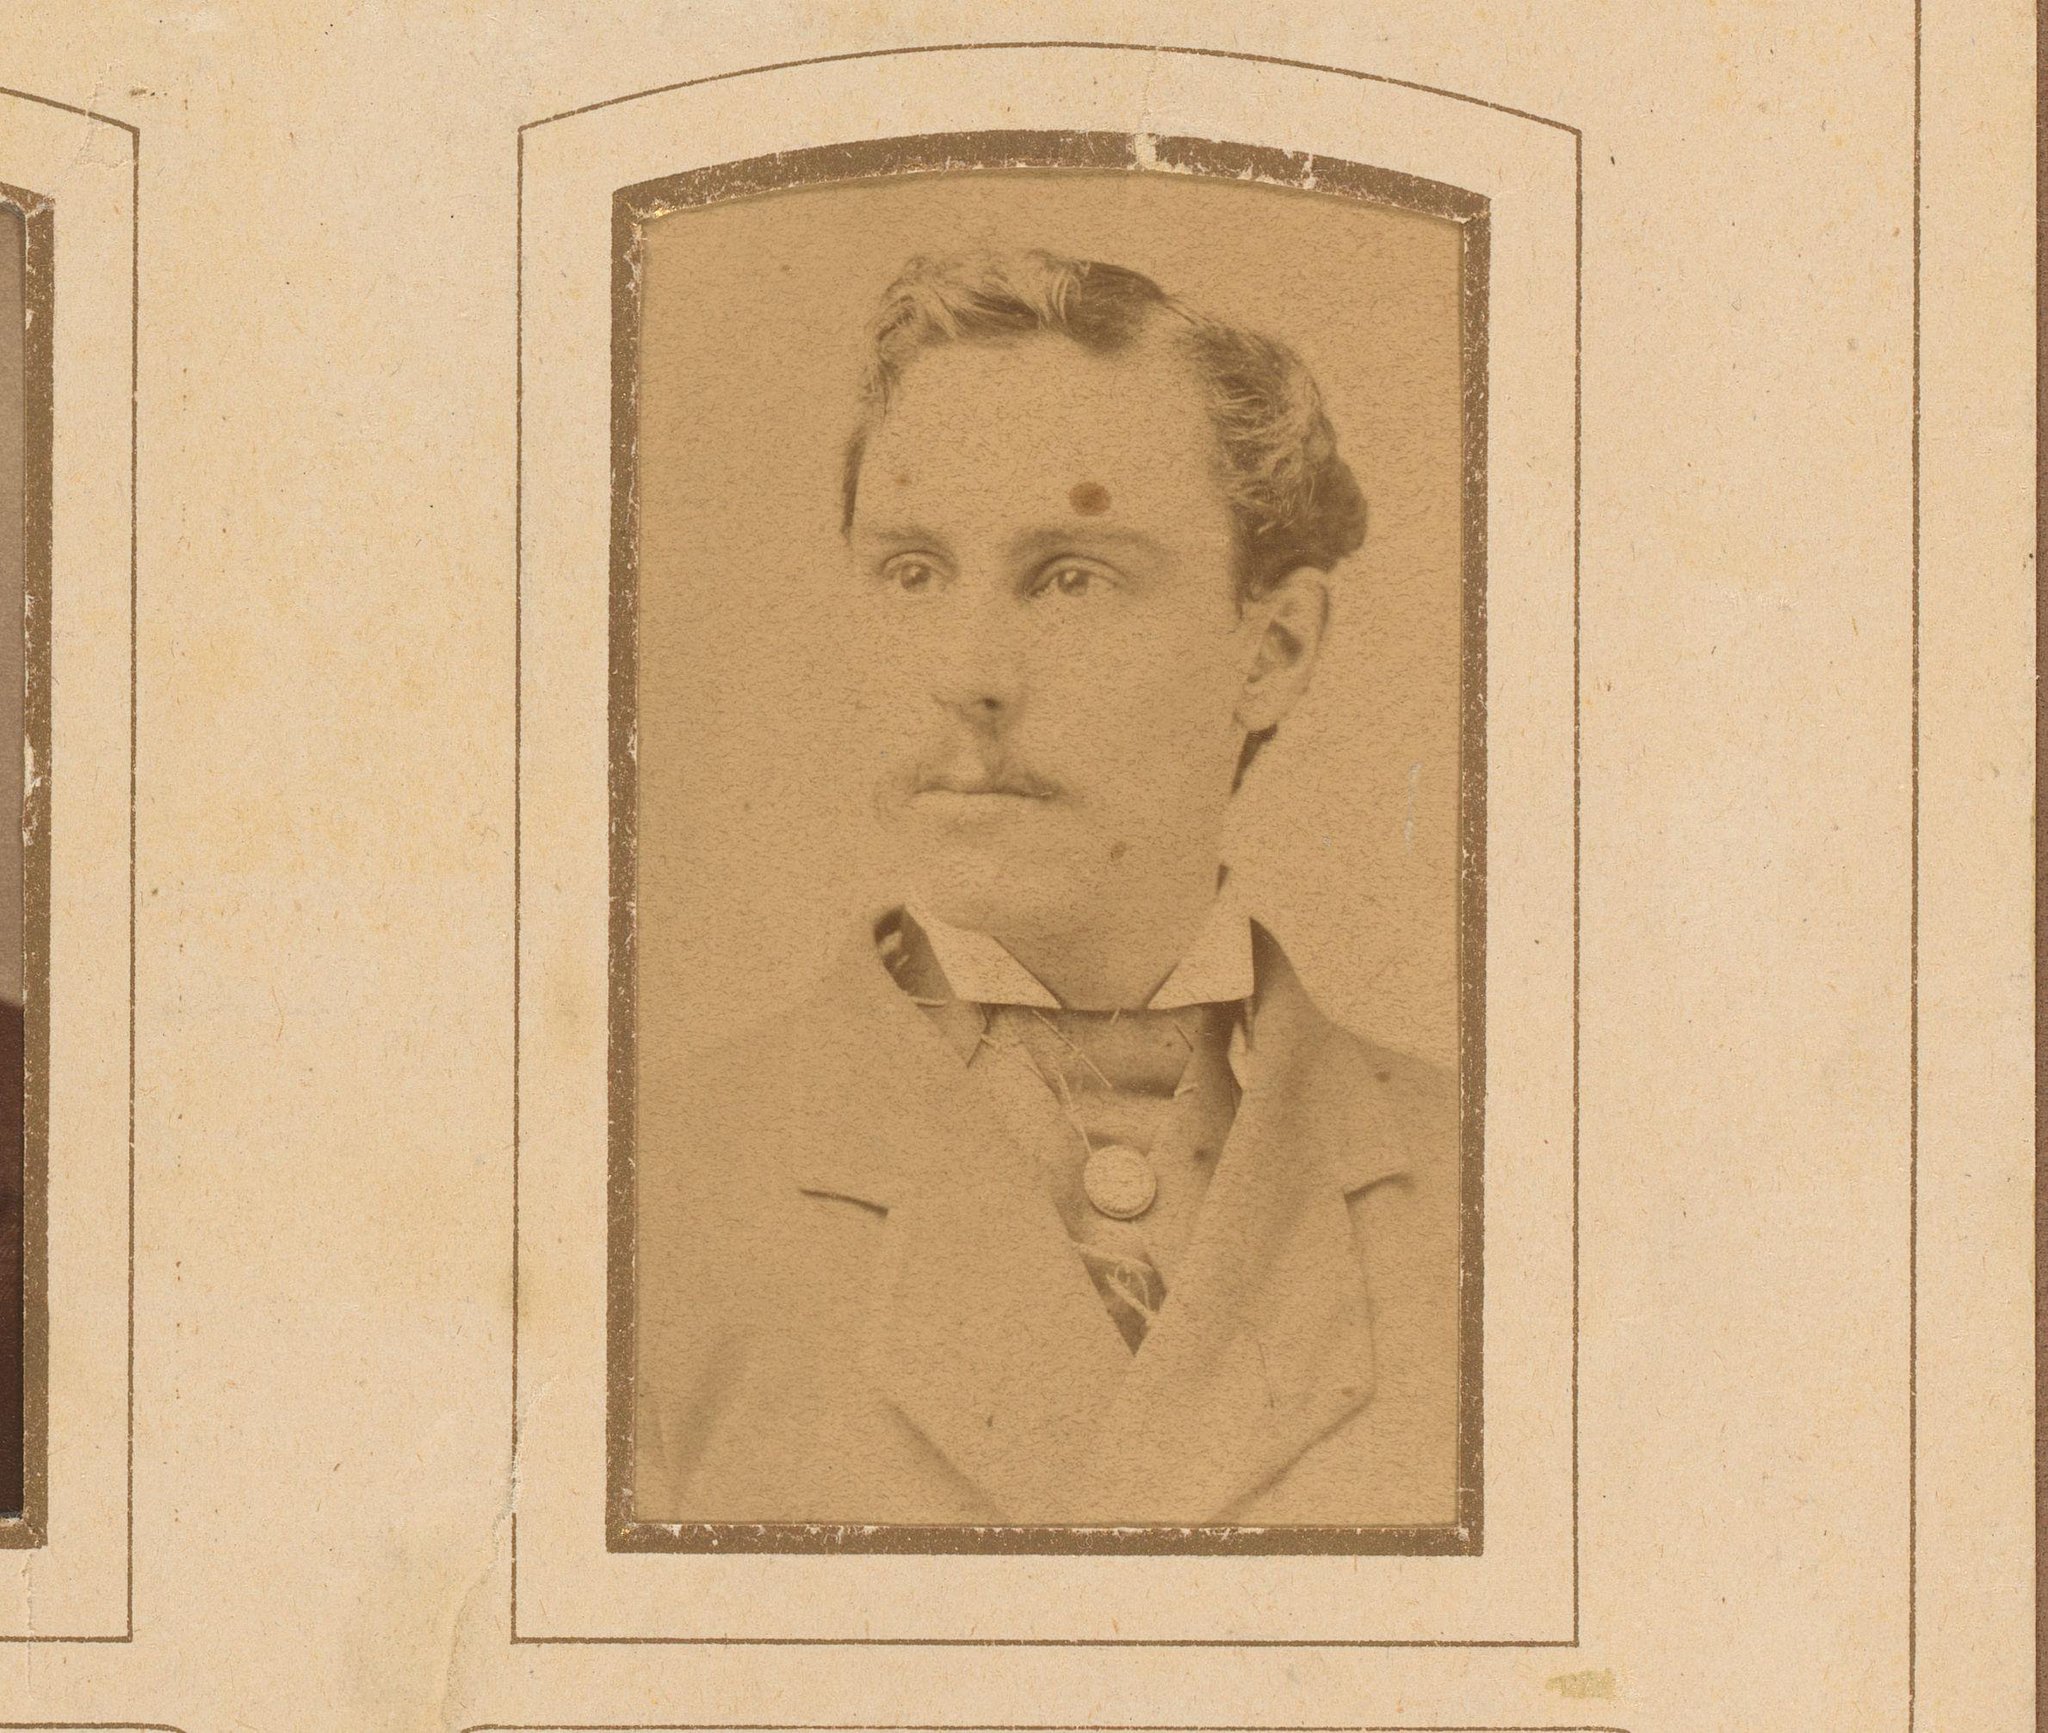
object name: album leaf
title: Portret van een man met snor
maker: george gardner rockwood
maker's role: fotograaf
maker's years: 1832-1911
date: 1870-1891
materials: cardboard, photographic support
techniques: albumen print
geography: new york city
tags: moustache, historical persons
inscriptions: inscription: ‘Rockwood/ Photographer/ 17/ UNION/ SQUARE/ (West)/ N.Y.’